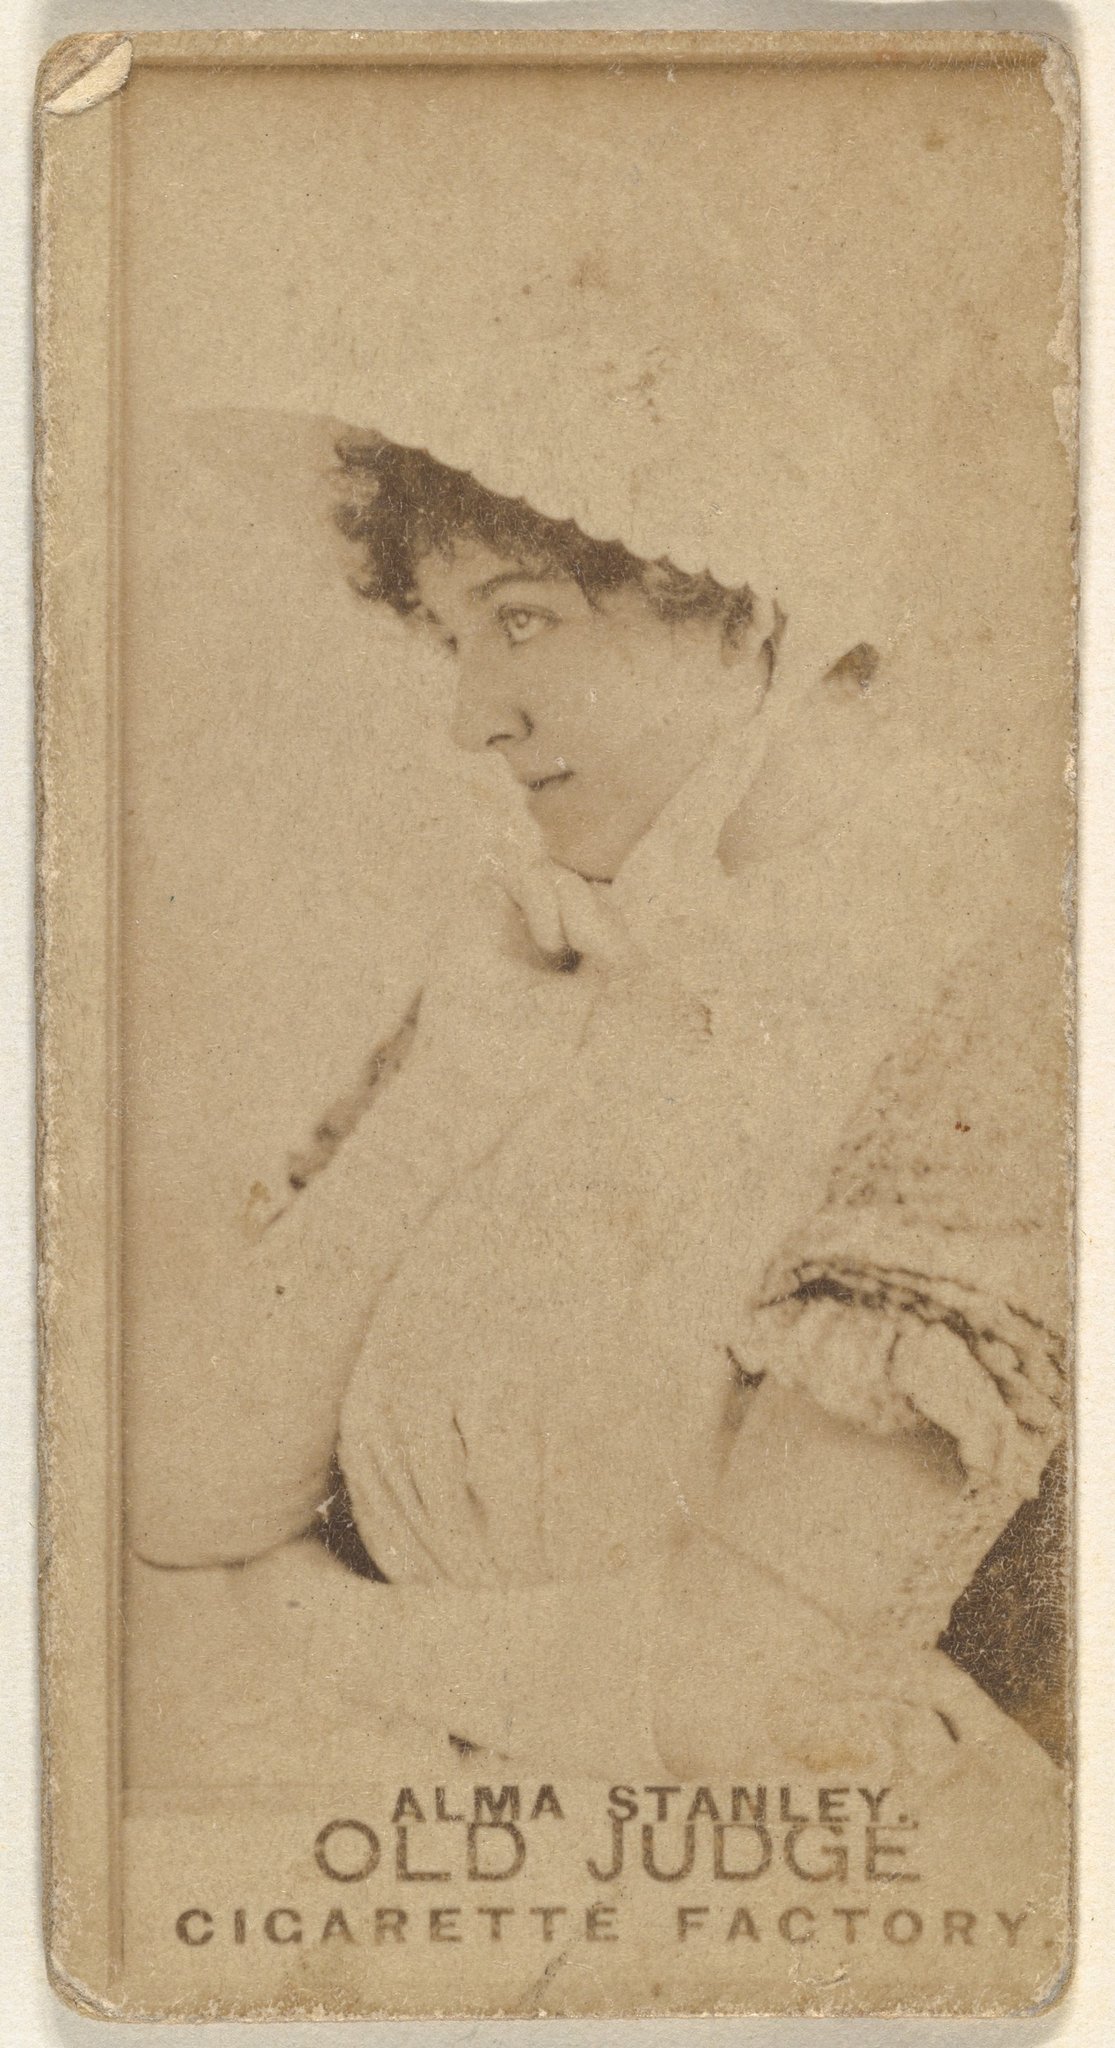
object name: photograph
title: Alma Stanley, from the Actors and Actresses series (N171) for Old Judge Cigarettes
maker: goodwin & company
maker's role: publisher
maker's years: 1850-1950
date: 1886-1890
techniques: albumen silver print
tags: profiles,women,actresses